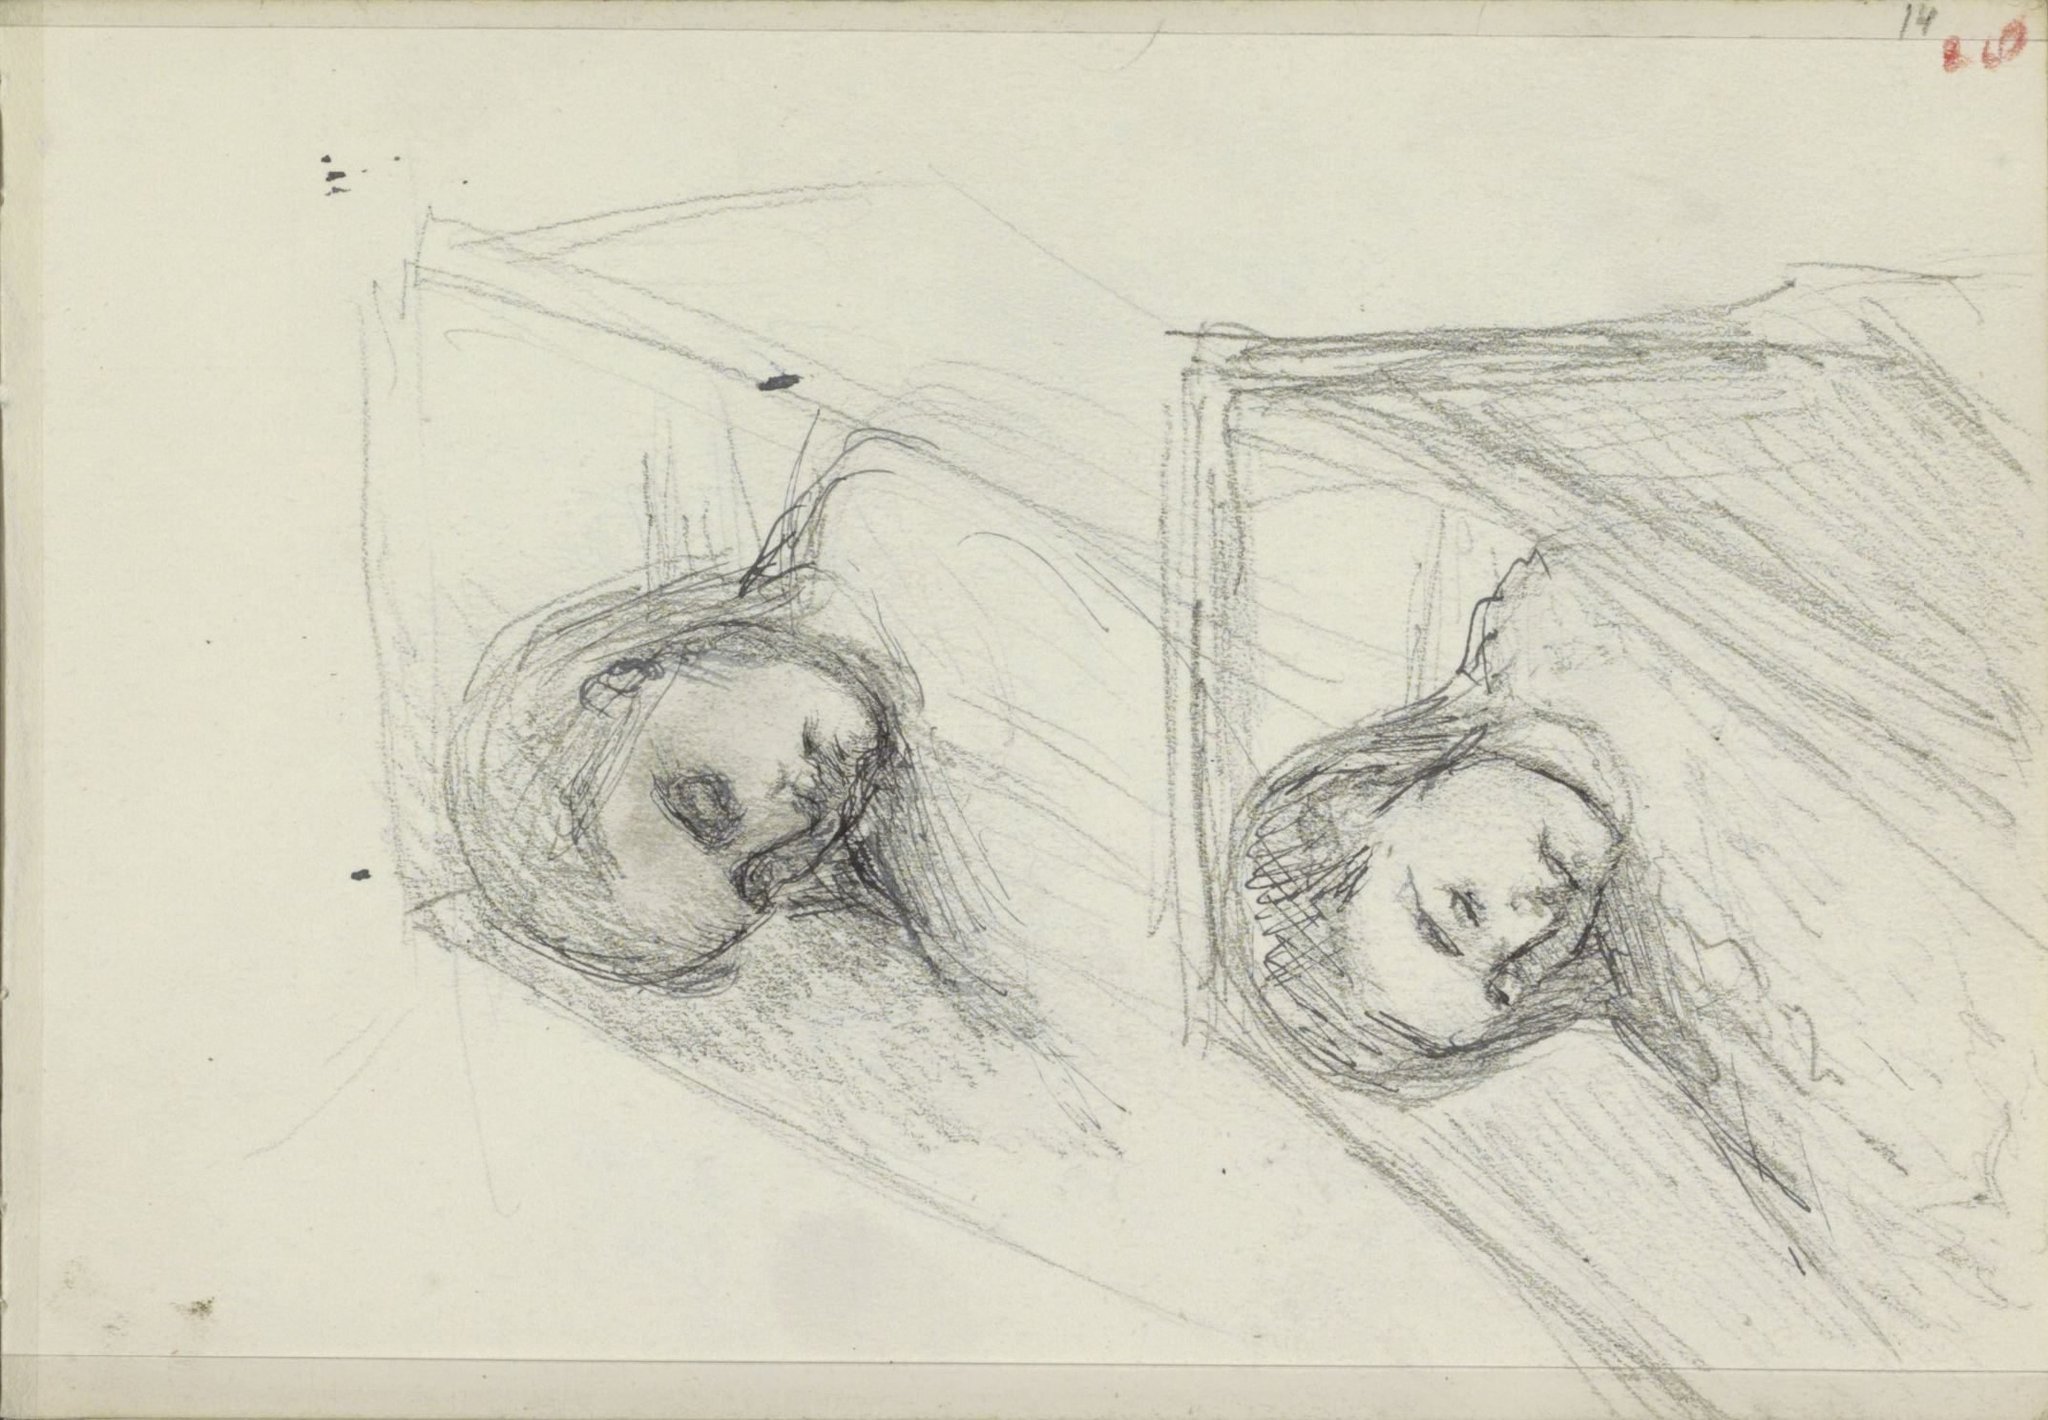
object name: sketchbook leaf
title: Meisje liggend met gebogen hoofd, vermoedelijk in een kist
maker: jozef israëls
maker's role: draughtsman, painter, print maker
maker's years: 1824-1911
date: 1885-1902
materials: ink, paper, pencil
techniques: pen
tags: lying figure - aa - female human figure (+ young female (human being)), coffin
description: Het meisje heeft de ogen gesloten en de kin op de borst. Blad 14 recto uit een schetsboek met 17 bladen.